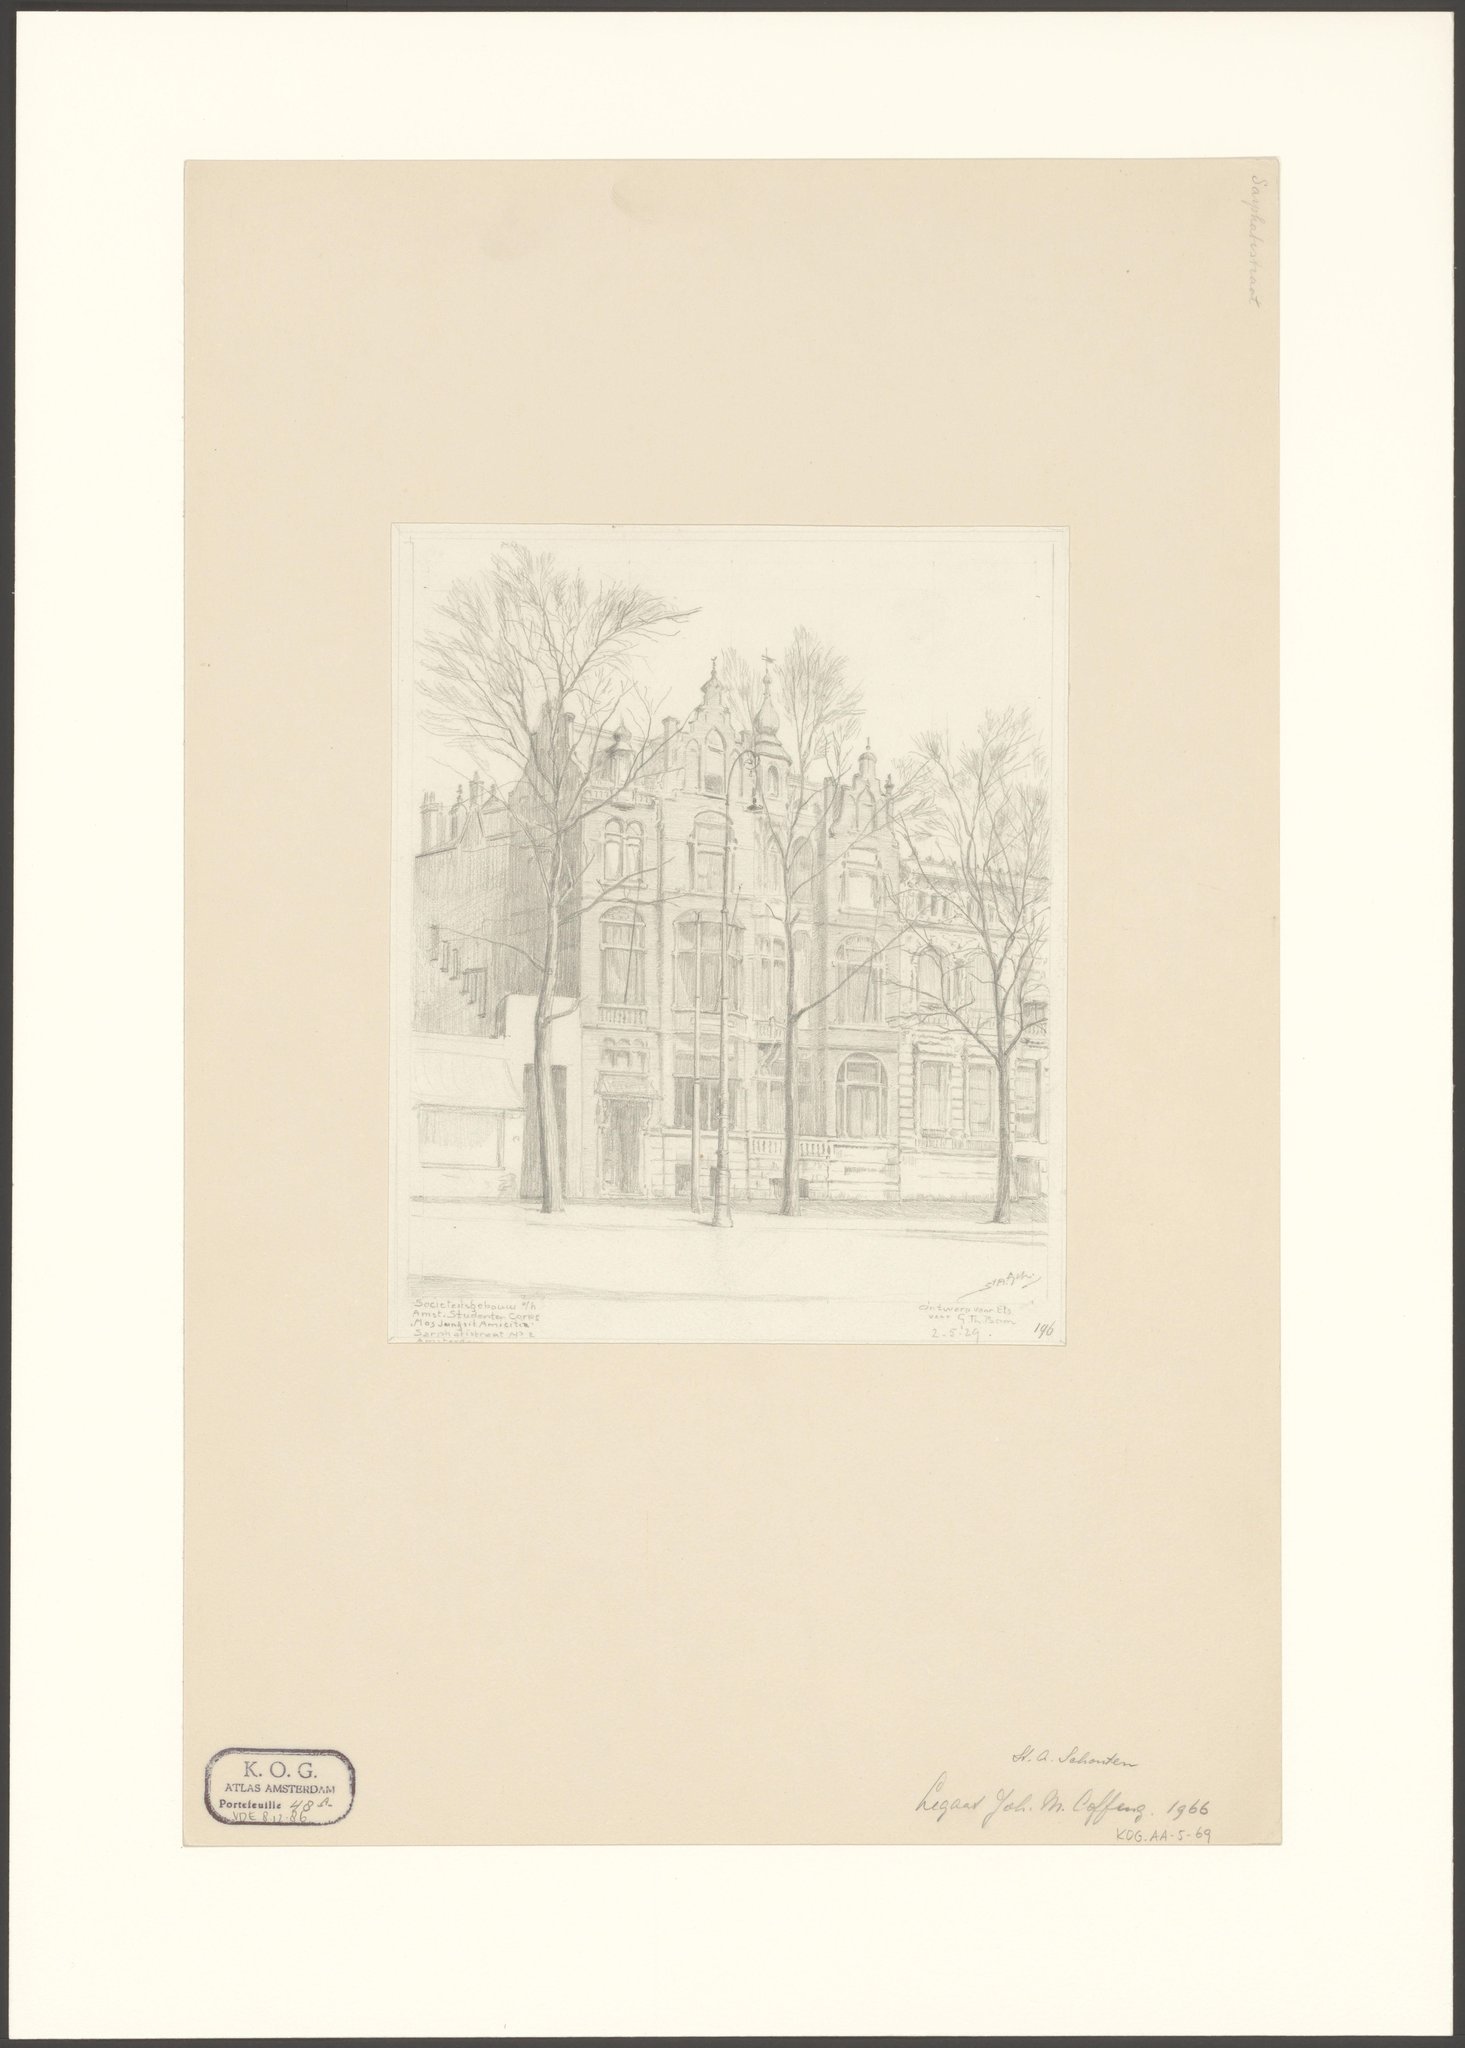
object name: drawing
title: Gezicht op het Sociëteitsgebouw van het Amsterdams Studenten Corps Nos Jungit Amicitia aan de Sarphatistraat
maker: Anonymous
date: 1929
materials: paper, pencil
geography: amsterdam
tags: city-view in general; 'veduta', façade (of house or building), street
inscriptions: inscription: ‘Societeitsgebouw v/h / Amst. (...) No 2 / Amsterdam’, collector's mark: ‘48A. / VDE 8.12.86’ Lugt 1641b, inscription: ‘Sarphatistraat / St. A. Schouten / Legaat Joh. M. Coffeng. 1966’, number: ‘36’, signature and date: ‘Sta. Sch. / ontwerp (...) 2-5-'29. 196’